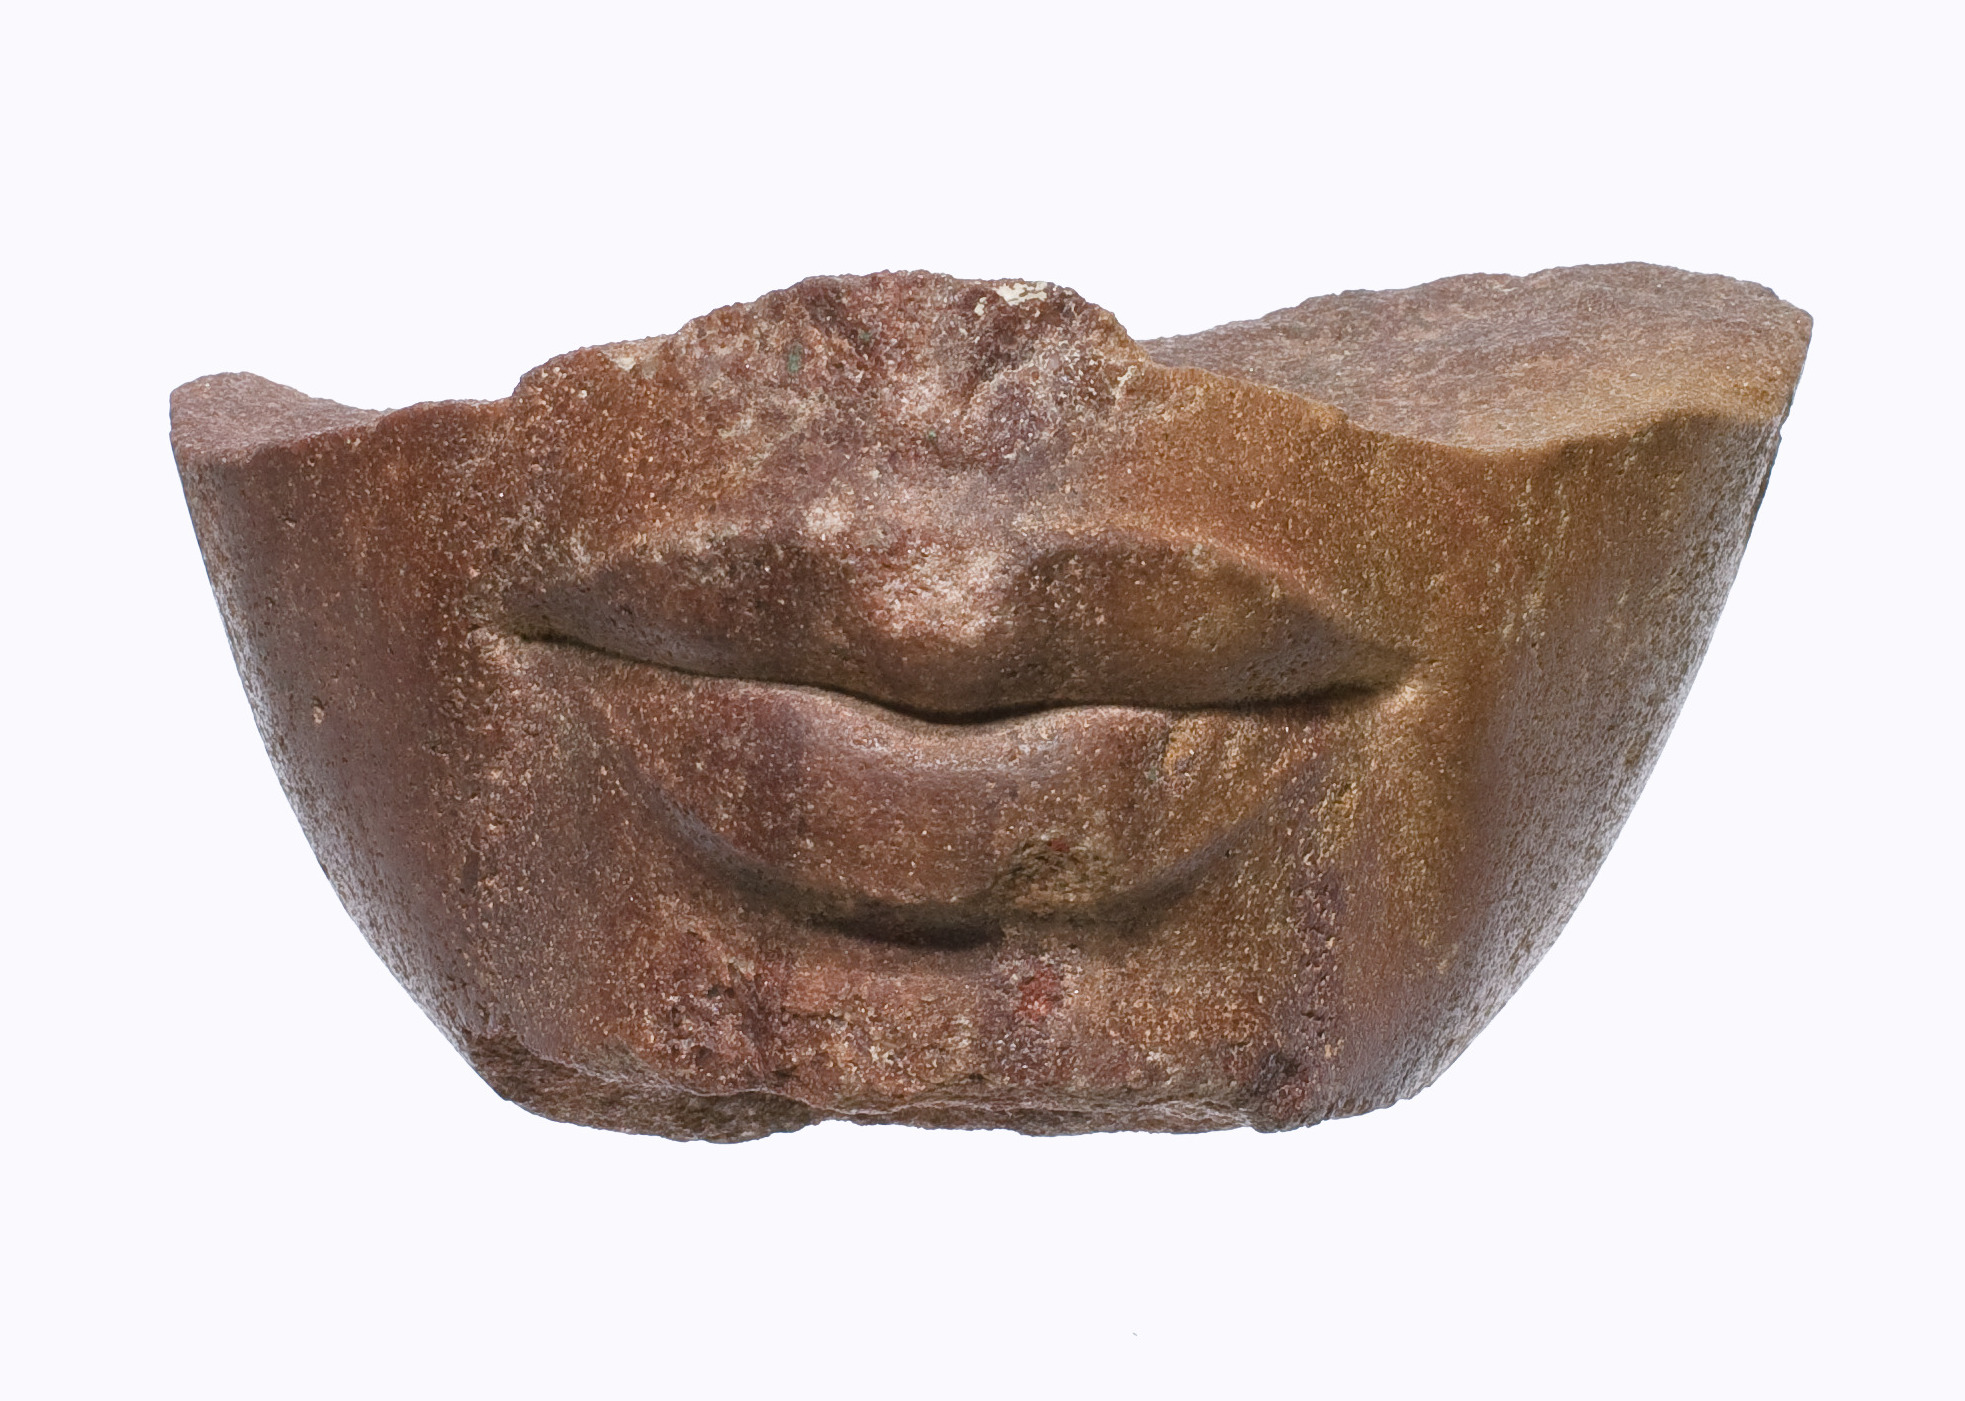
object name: head, royal, lower part of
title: Lower part of a royal head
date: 1353-1336 BCE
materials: quartzite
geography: middle egypt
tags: heads